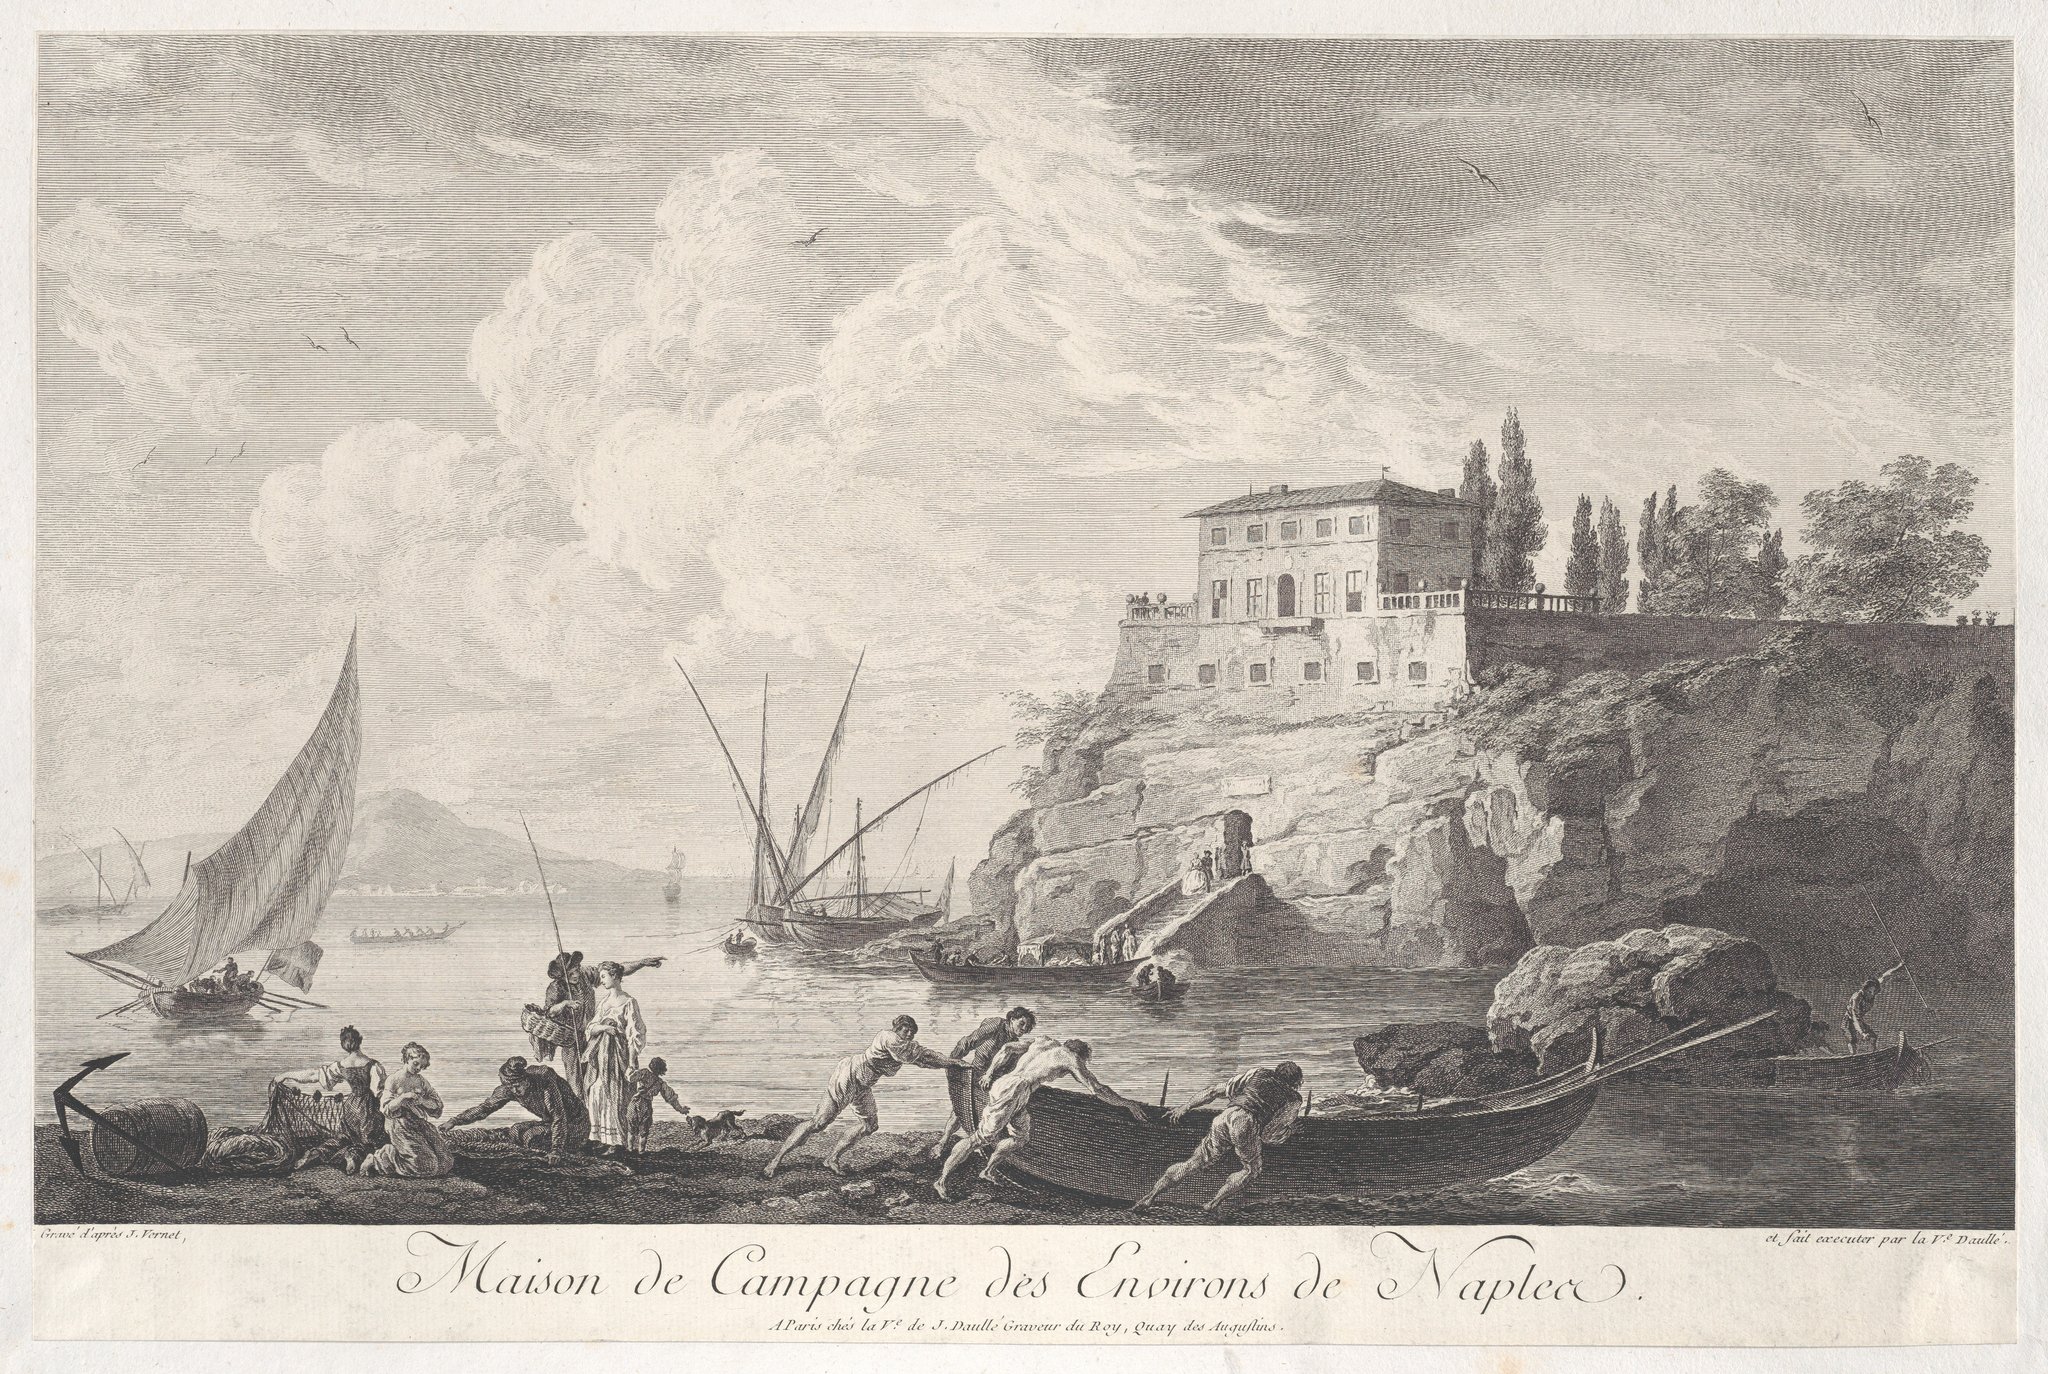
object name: print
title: House in the Country Surrounding Naples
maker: joseph vernet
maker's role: artist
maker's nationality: french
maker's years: 1714-1789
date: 1720-1760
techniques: engraving